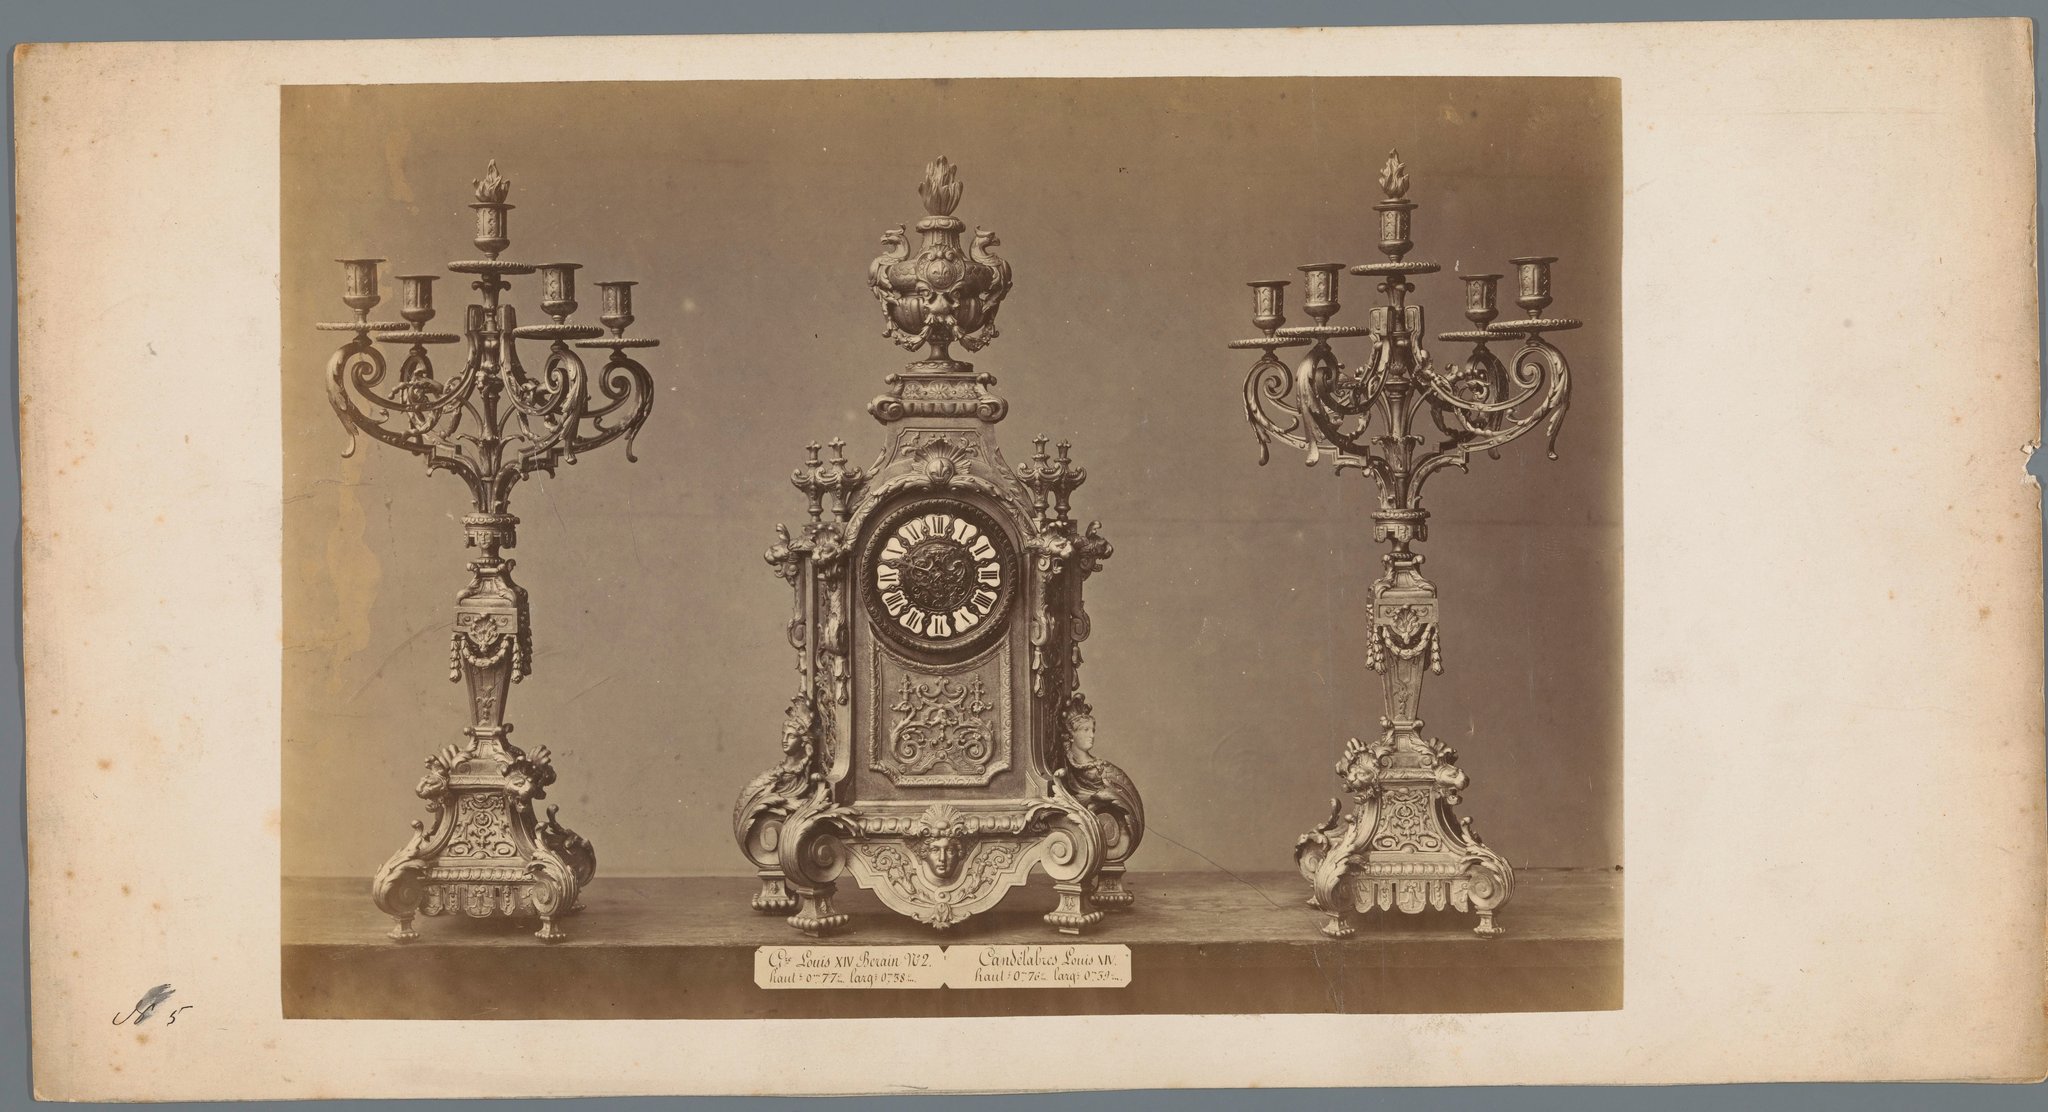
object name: photograph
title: Garniture Louis XIV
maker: Anonymous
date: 1875-1900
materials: cardboard, photographic support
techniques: albumen print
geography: europe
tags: lion's head ~ ornament, chandelier, candelabrum, clock, europe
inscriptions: inscription: ‘No520 720 [...]tuur XX pl 7’, number: ‘No 2.’, inscription: ‘hautr 0m77cm largr 0m38cm Candélabres Louis XIV hautr 0m76cm largr 0m59cm’, collector's mark: Lugt 3937